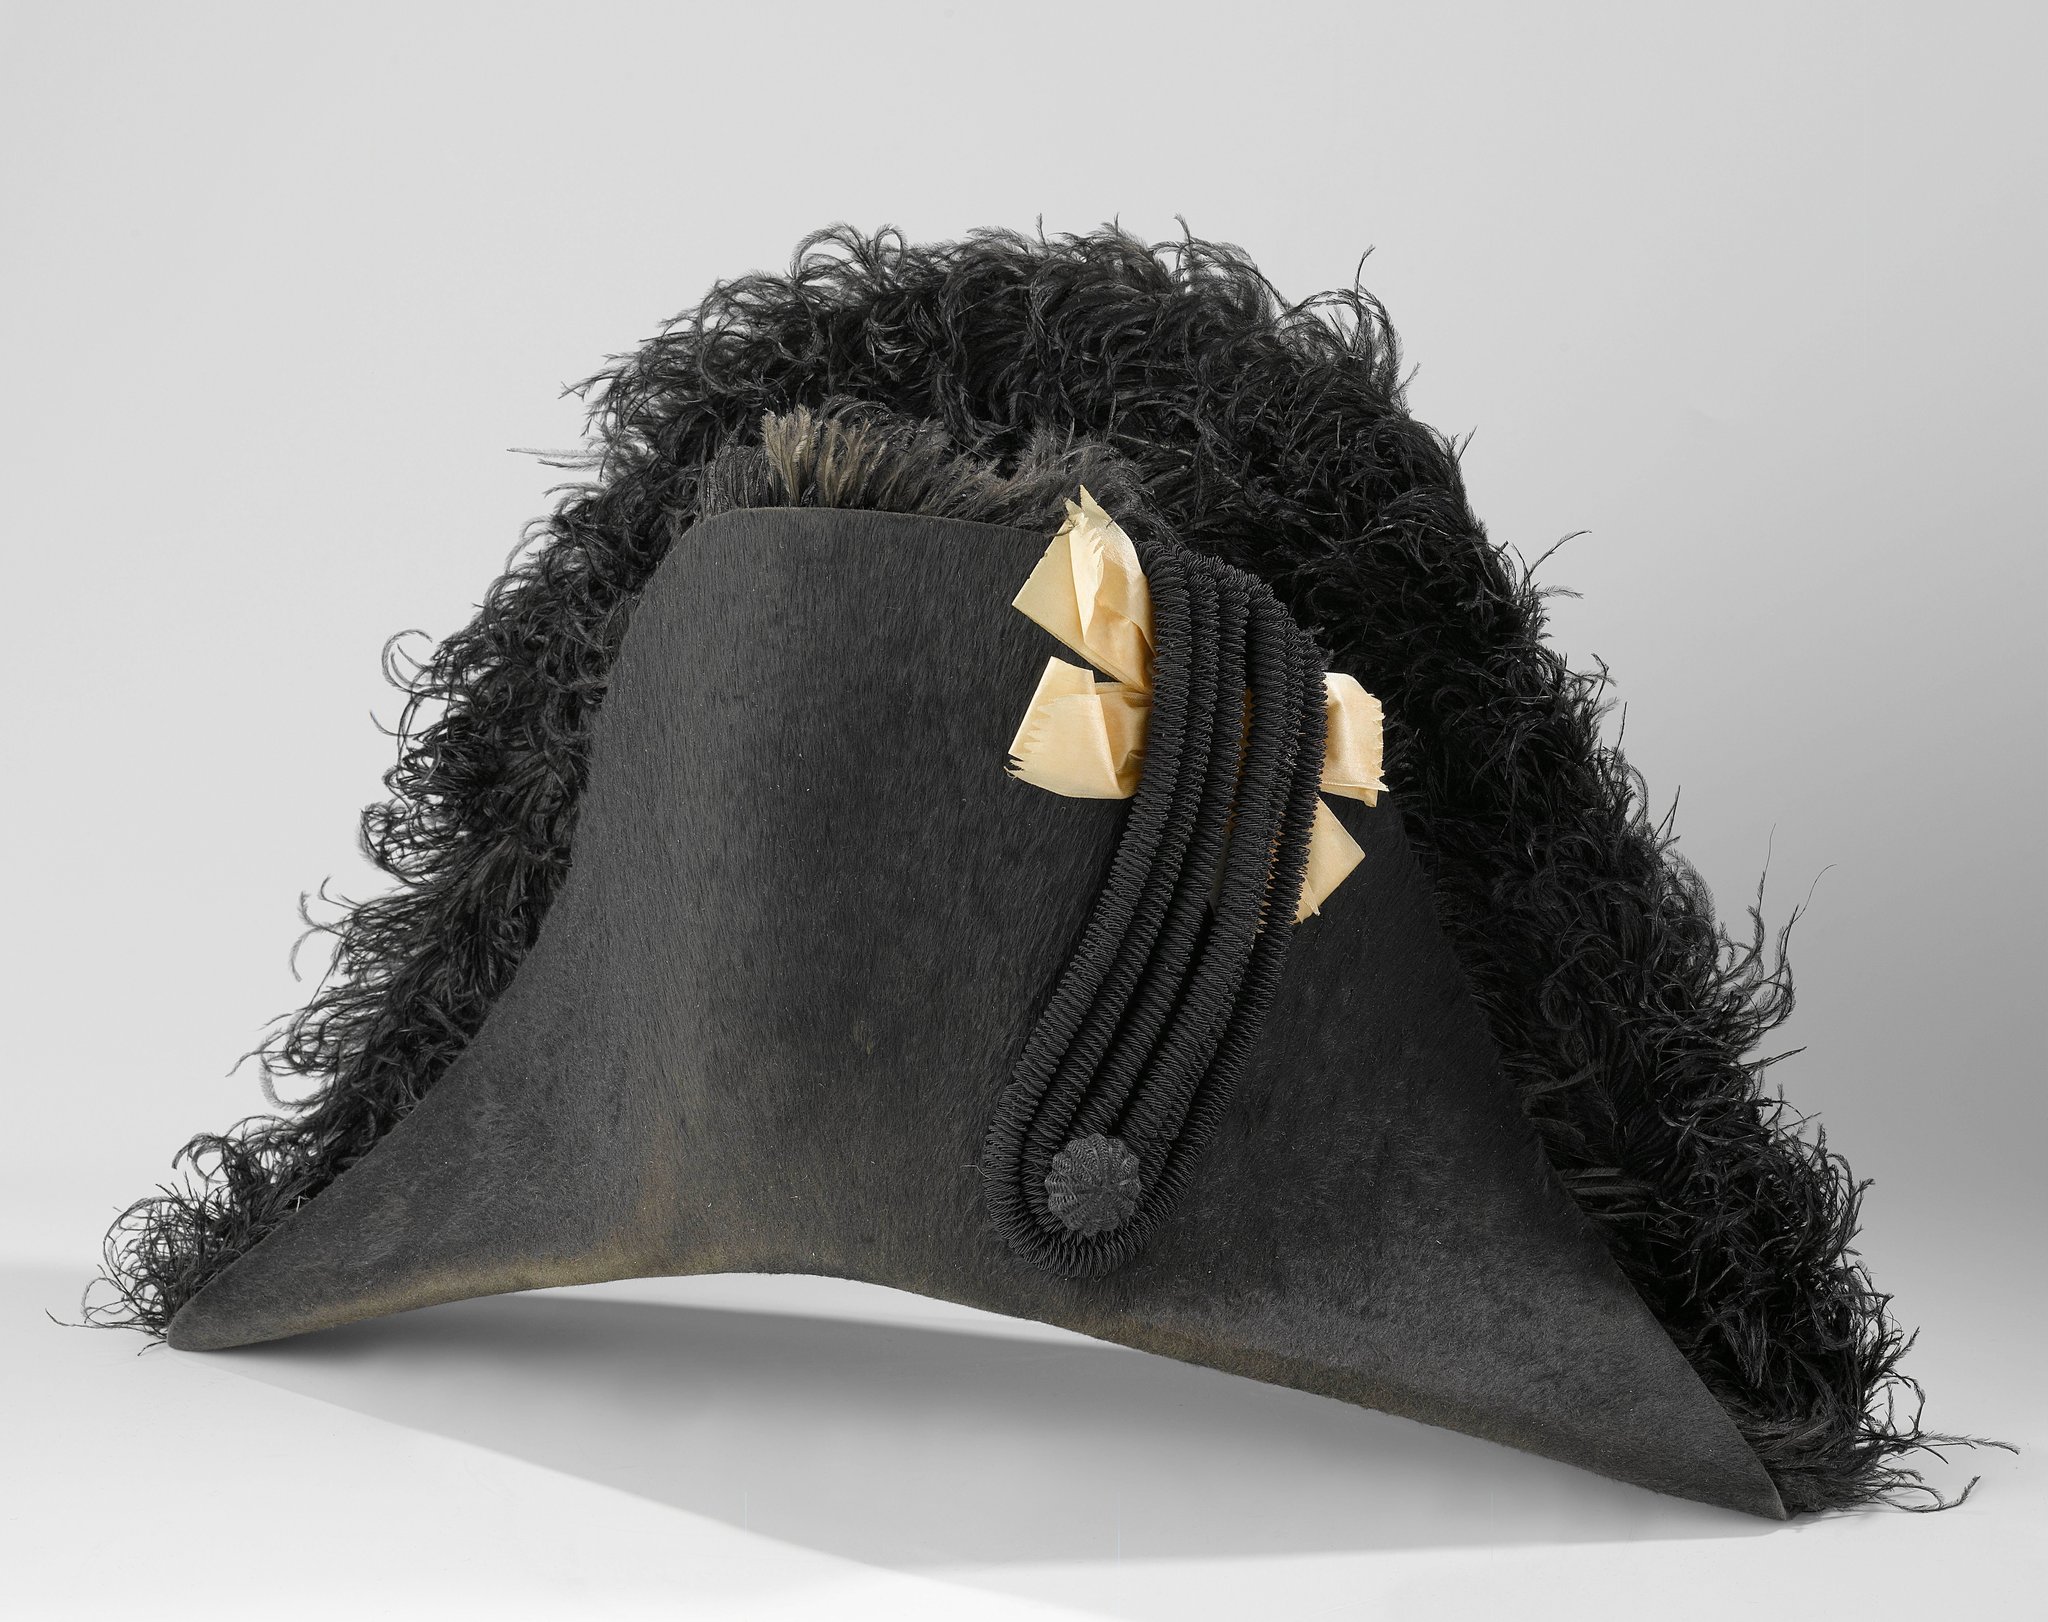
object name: hoofddeksel, hoofdbedekking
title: Ronde rouwsteek van zwart haarvilt, versierd met zwarte struisveren en een zwarte lis over een oranje strik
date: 1789-1810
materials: leather, silk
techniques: moire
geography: kalverstraat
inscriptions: address: ‘G. Nijman // In alle Soorten van Hoeden // Kalverstraat over de Sint Luciënsteeg // No. 207 // Amsterdam’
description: Rouwsteek van zwart haarvilt. Model: tweepuntig, met ronde bol. De bladen zijn afgezet met zwarte struisveren. Het ene blad is hoog; het andere blad is lager en versierd met een oranje strik waarover een zwarte lis is gezet, die is vast gezet met een zwarte knoop. Zwarte moiré voering.